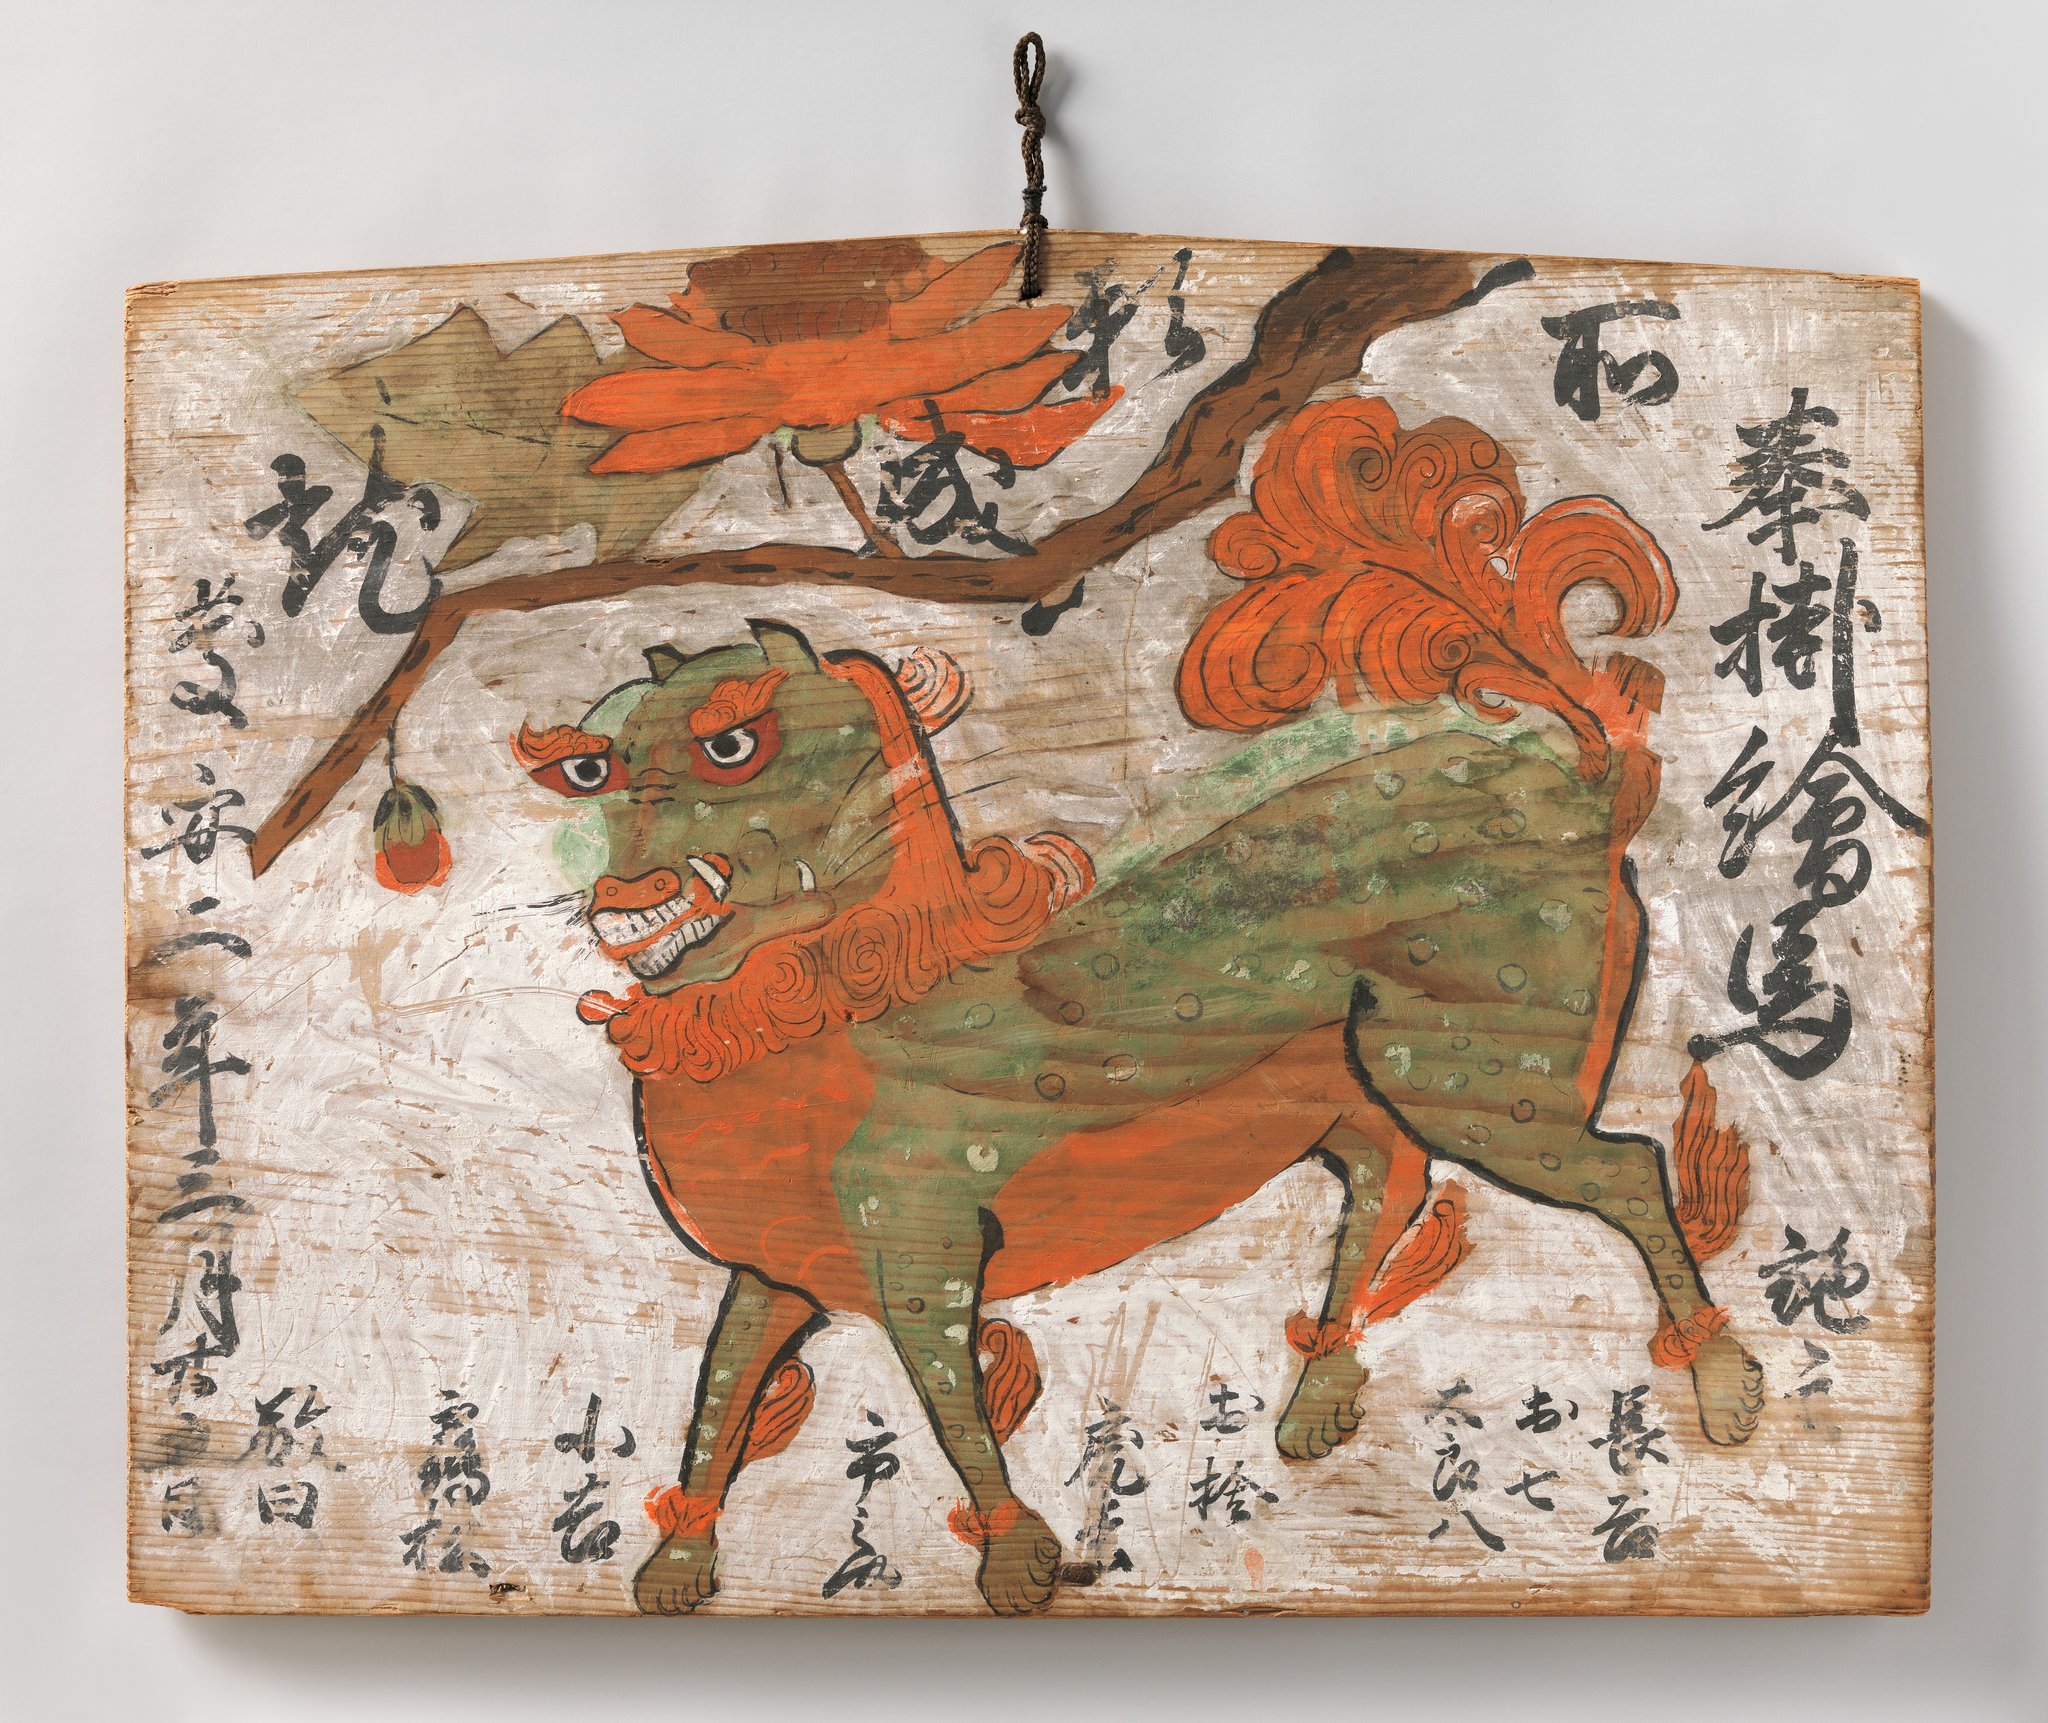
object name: votive painting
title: Ema (Votive Painting) of Chinese Lion and Peony Tree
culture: japanese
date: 1649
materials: ink, wood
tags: lions